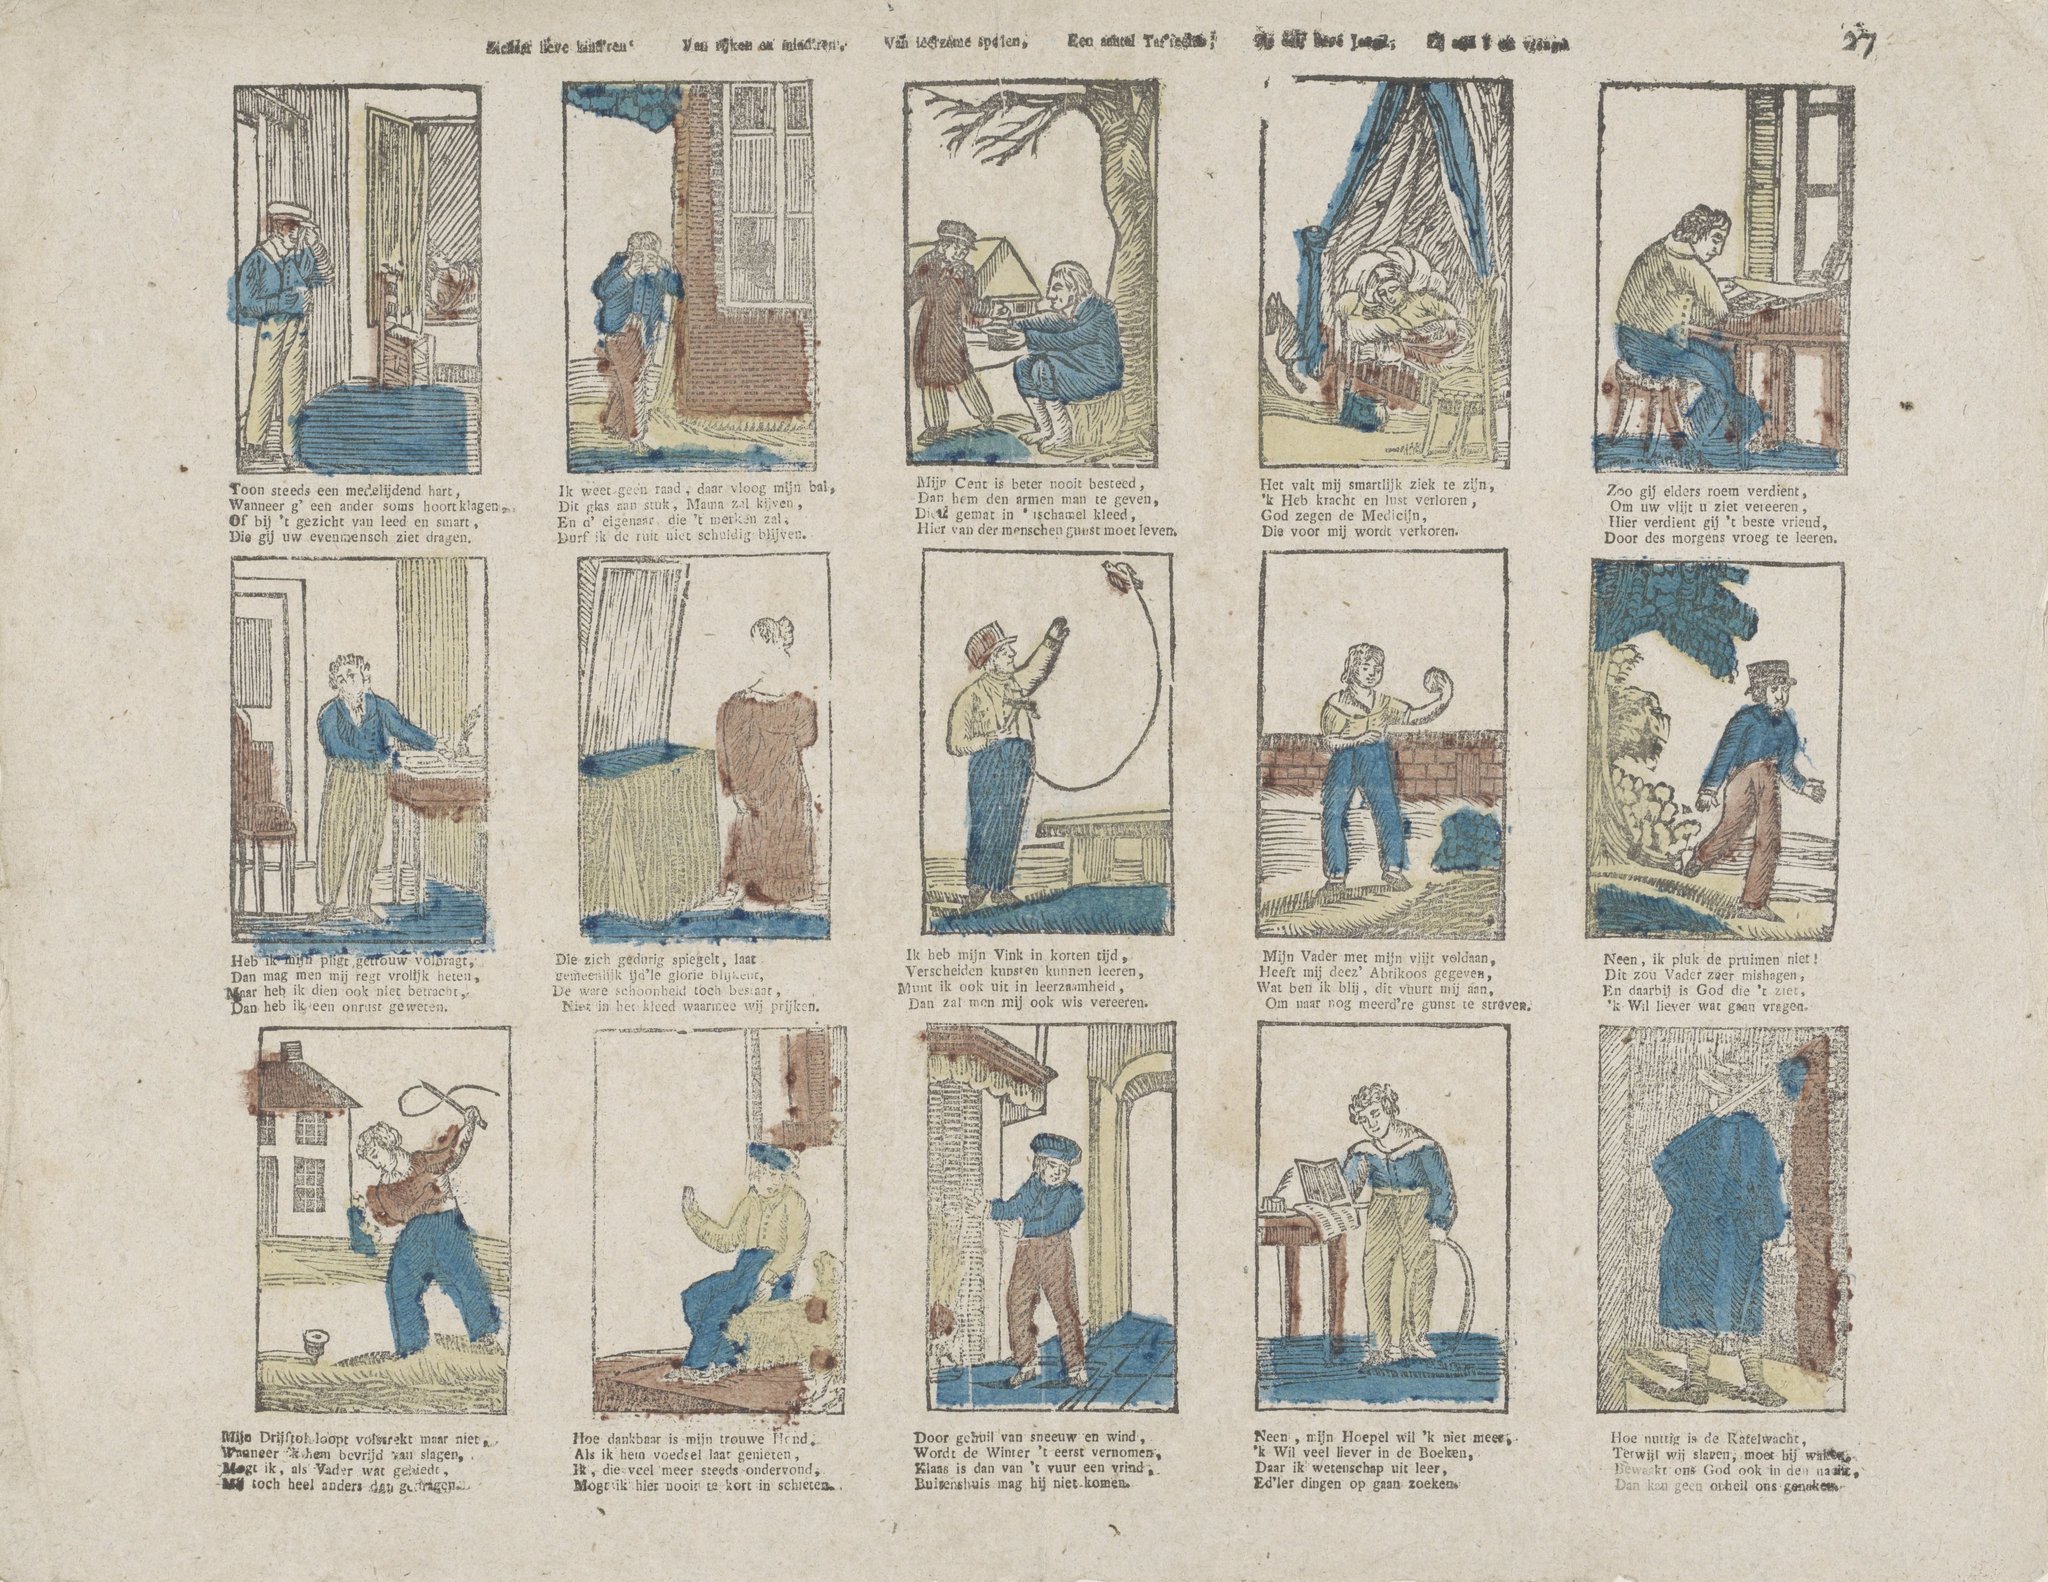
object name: popular print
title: Zie hier lieve kind'ren / Van rijken en van mind'ren [(...)]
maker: Anonymous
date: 1700-1899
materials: paper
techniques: colour, letterpress printing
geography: netherlands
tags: children's games and plays, games using special objects (marbles, top, hoop, etc.)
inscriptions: collector's mark: Lugt 2760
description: Blad met 15 voorstellingen van kinderspelen en bezigheden, zoals lezen en tollen. Onder elke voorstelling een vierregelig vers. Genummerd rechtsboven: 27.